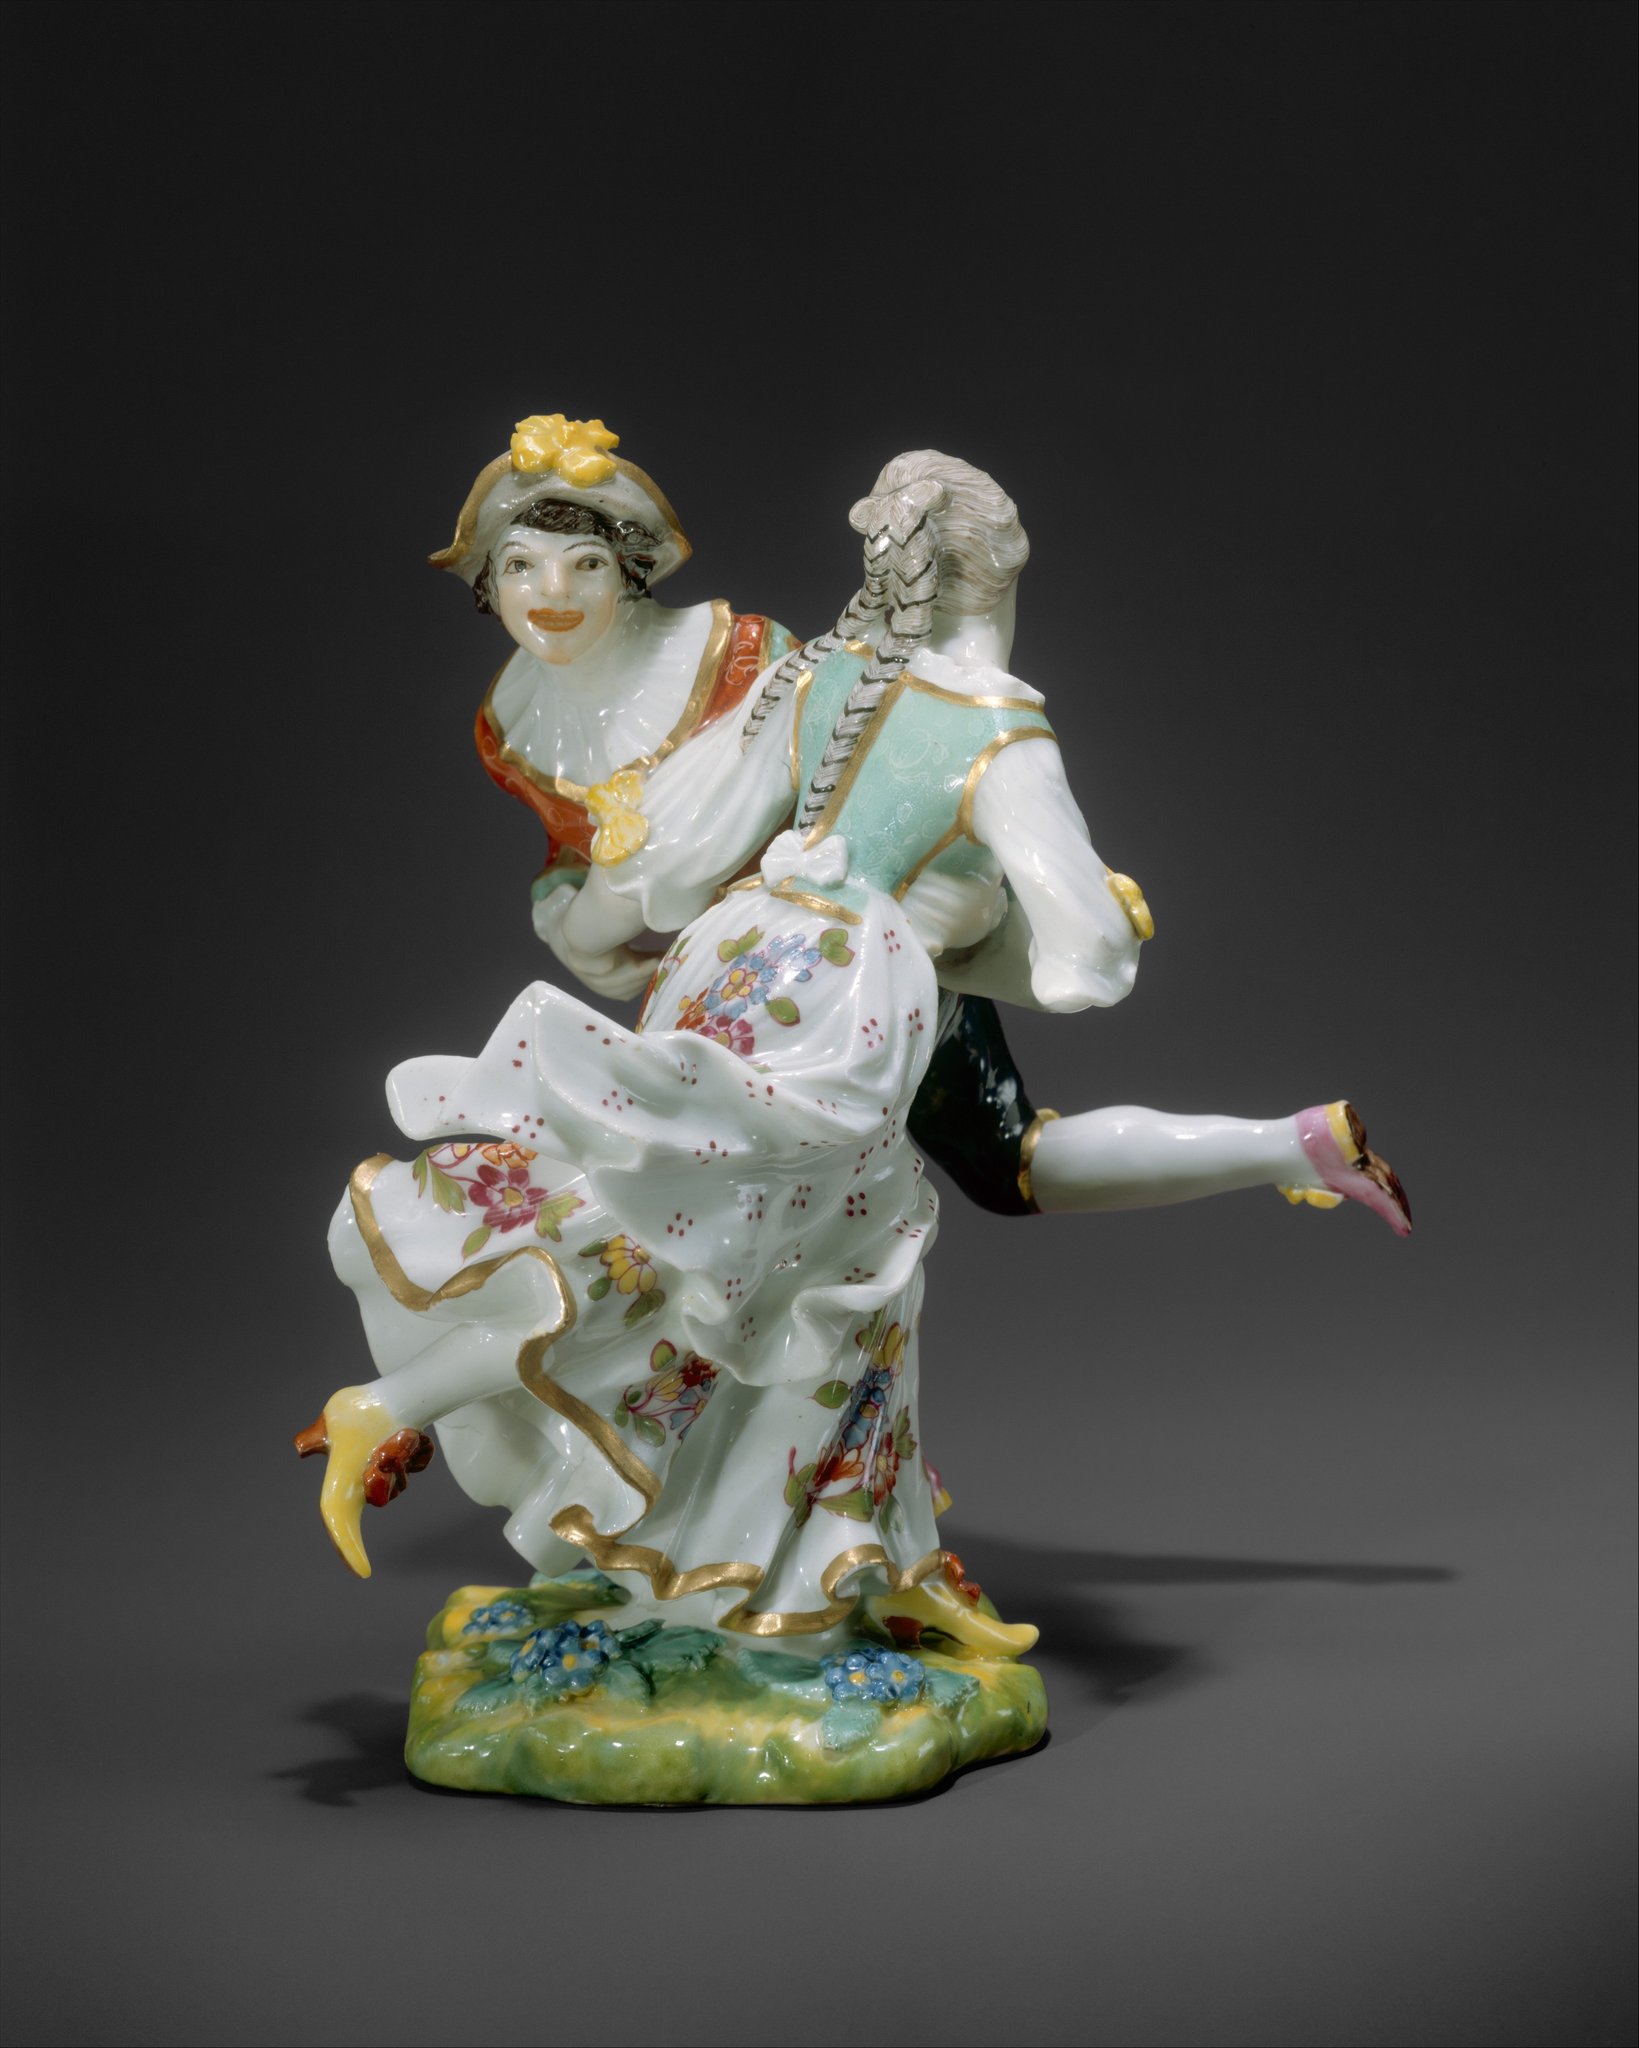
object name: group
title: Peasant Dancers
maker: johann friedrich eberlein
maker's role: modeler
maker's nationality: german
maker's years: 1695-1749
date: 1735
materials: hard paste porcelain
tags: men,women,dancing,dancers